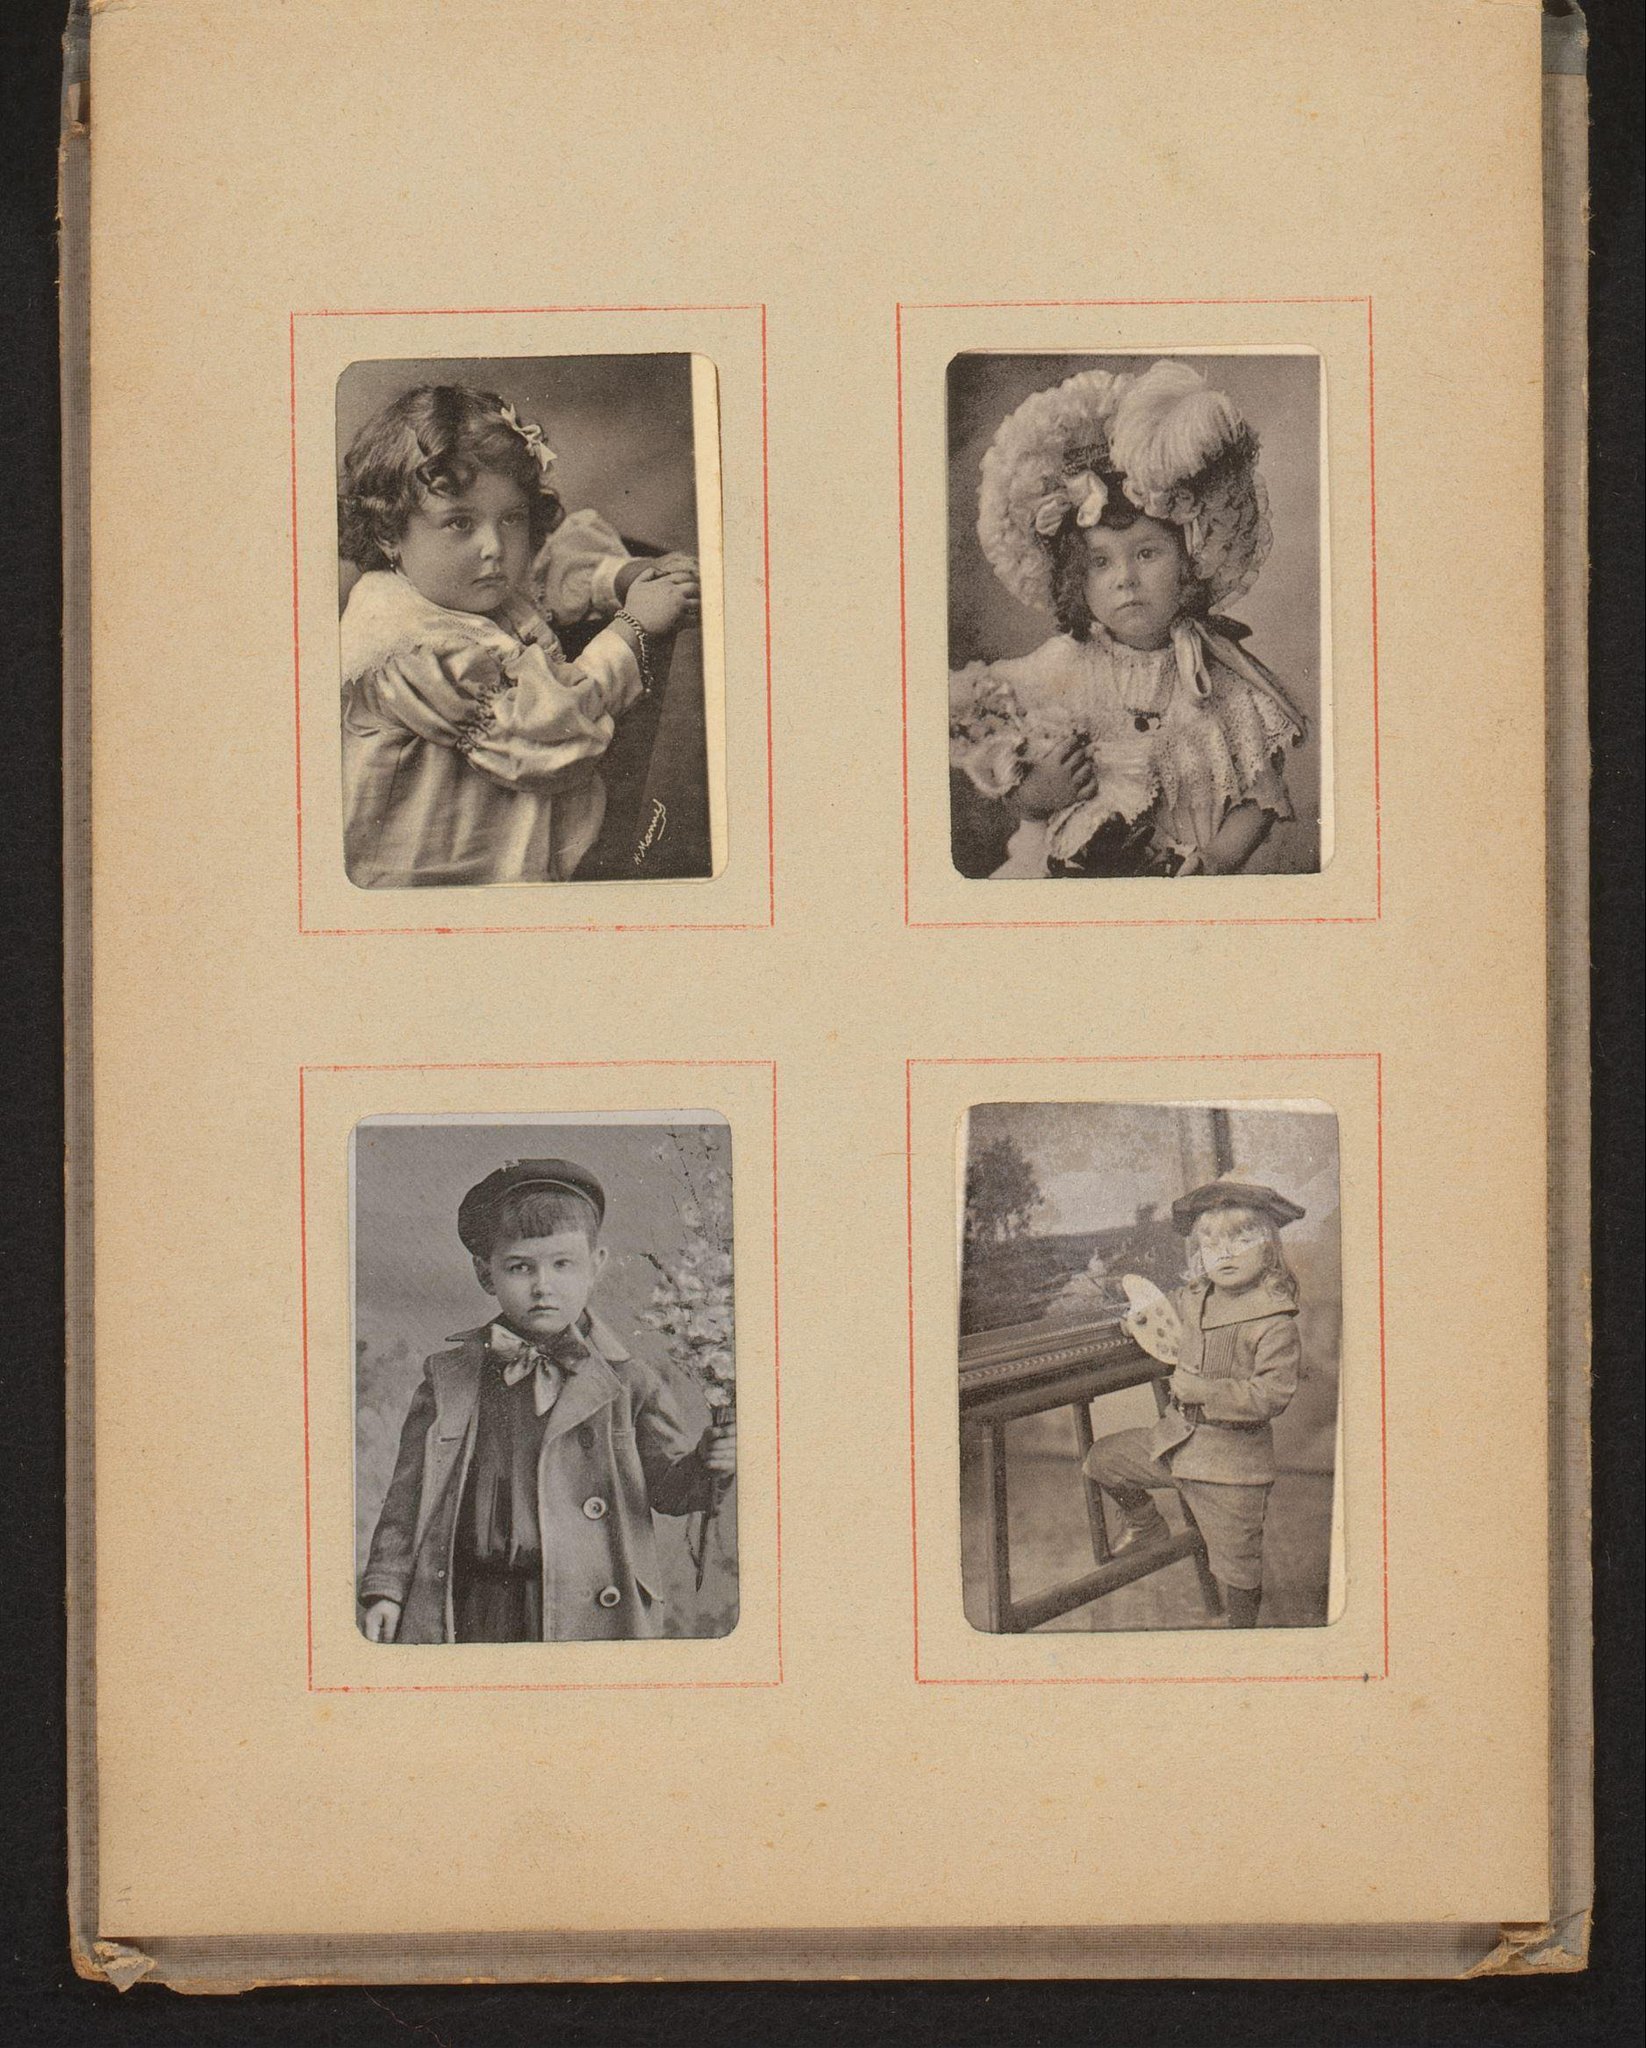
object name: album leaf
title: Kinderportretten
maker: Anonymous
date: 1880-1920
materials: paper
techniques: photograph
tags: head-gear, child, historical persons, trade games, imitative games, imitating adults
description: Vier portretten van kinderen, waaronder een van een meisje verkleed als schilder. Deze pagina maakt deel uit van een album.